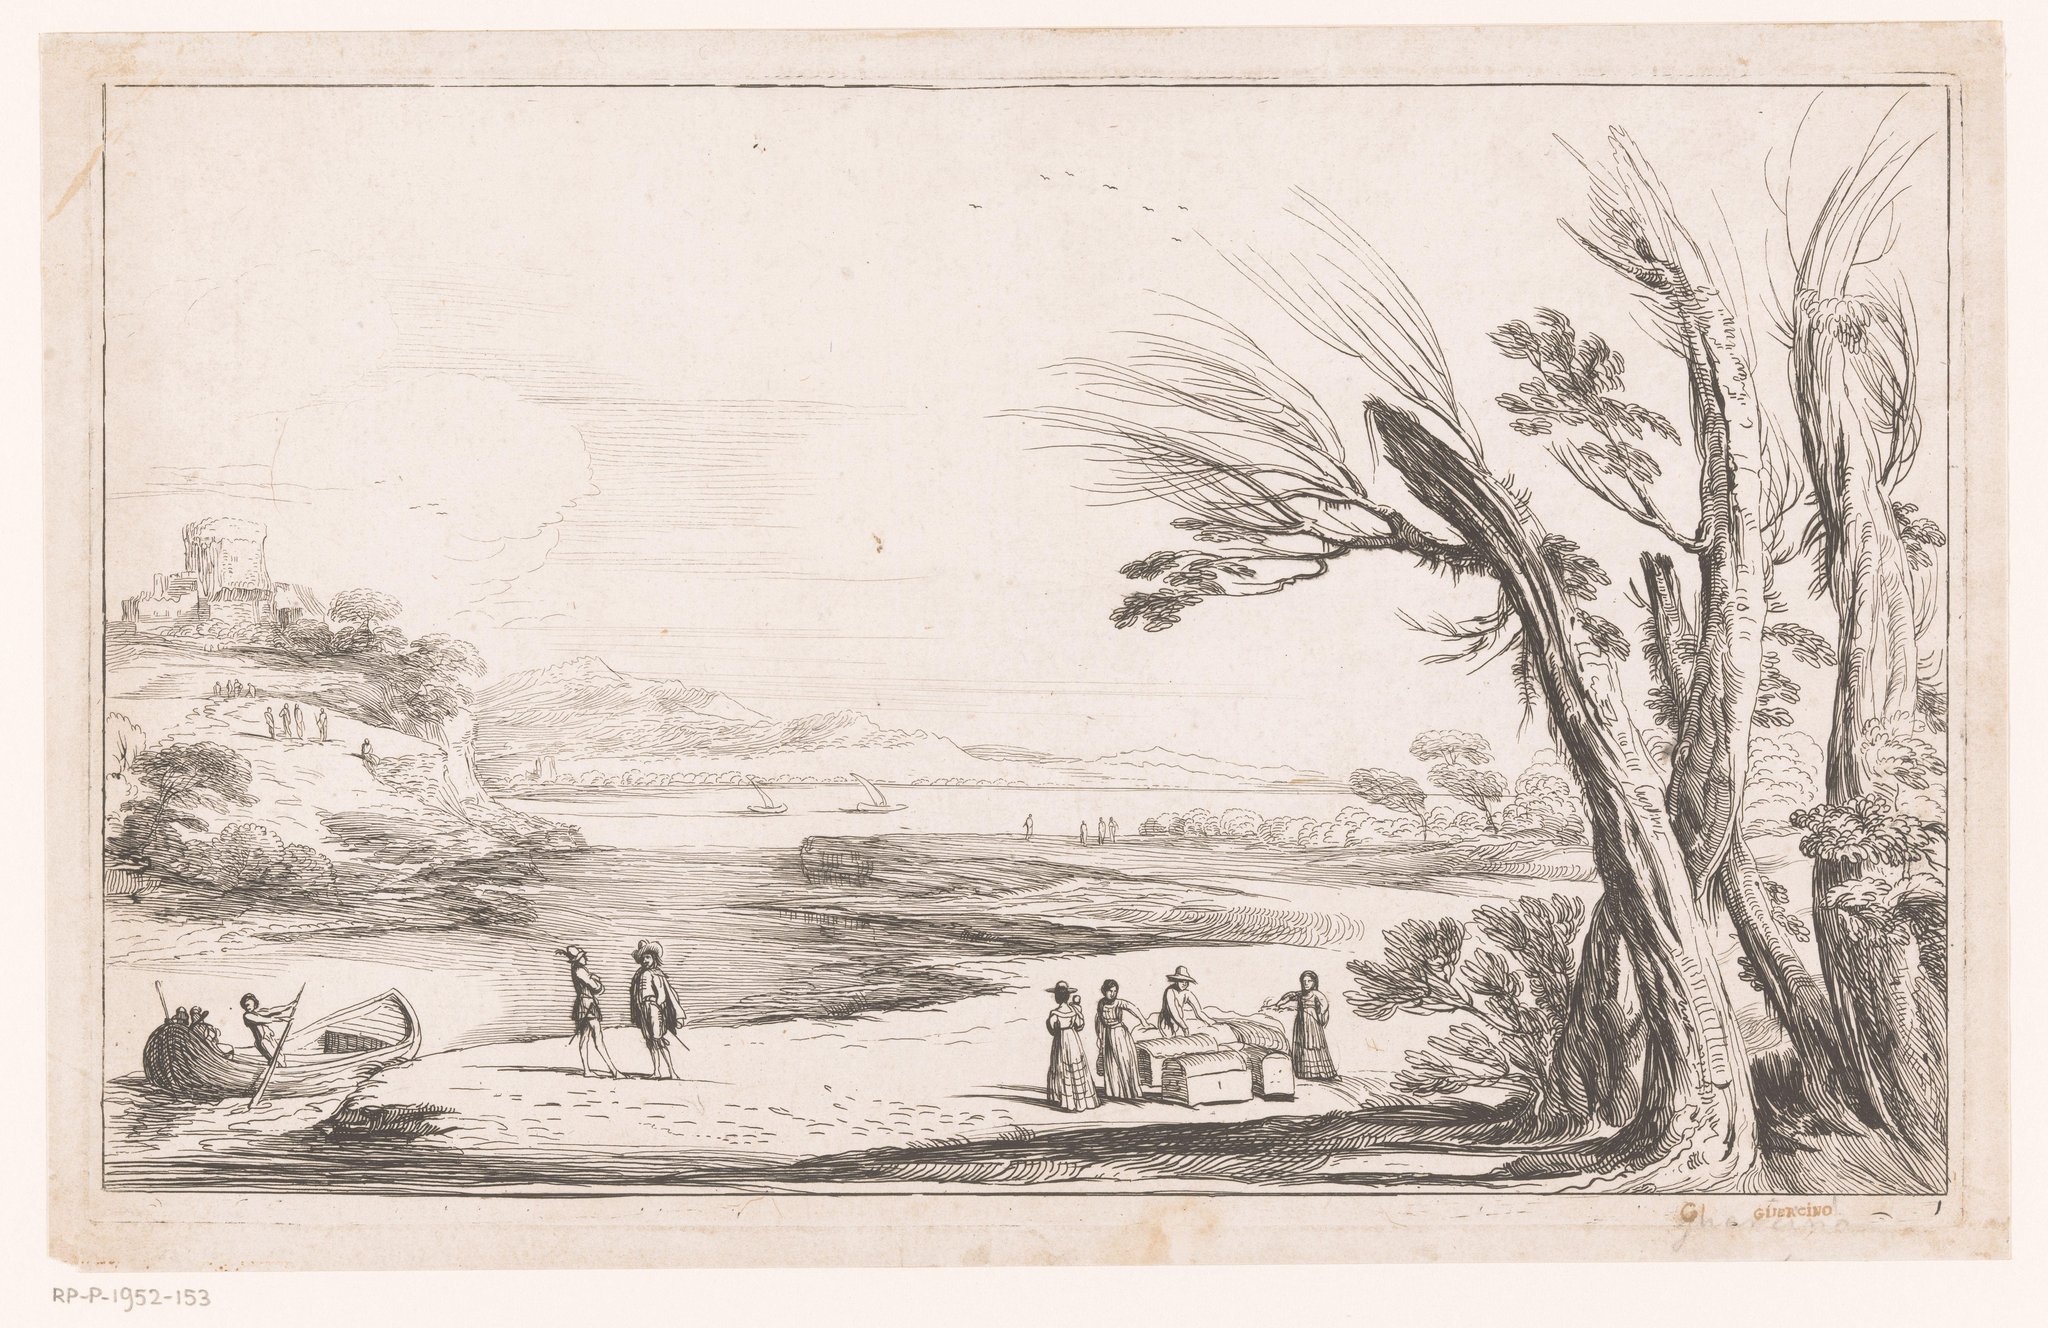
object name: print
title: Reizigers met bagage bij een rivier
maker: jean pesne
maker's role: print maker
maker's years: 1623-1700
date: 1633-1700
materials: paper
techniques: etching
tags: luggage, travel requisites, water course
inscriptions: collector's mark: Lugt 2228